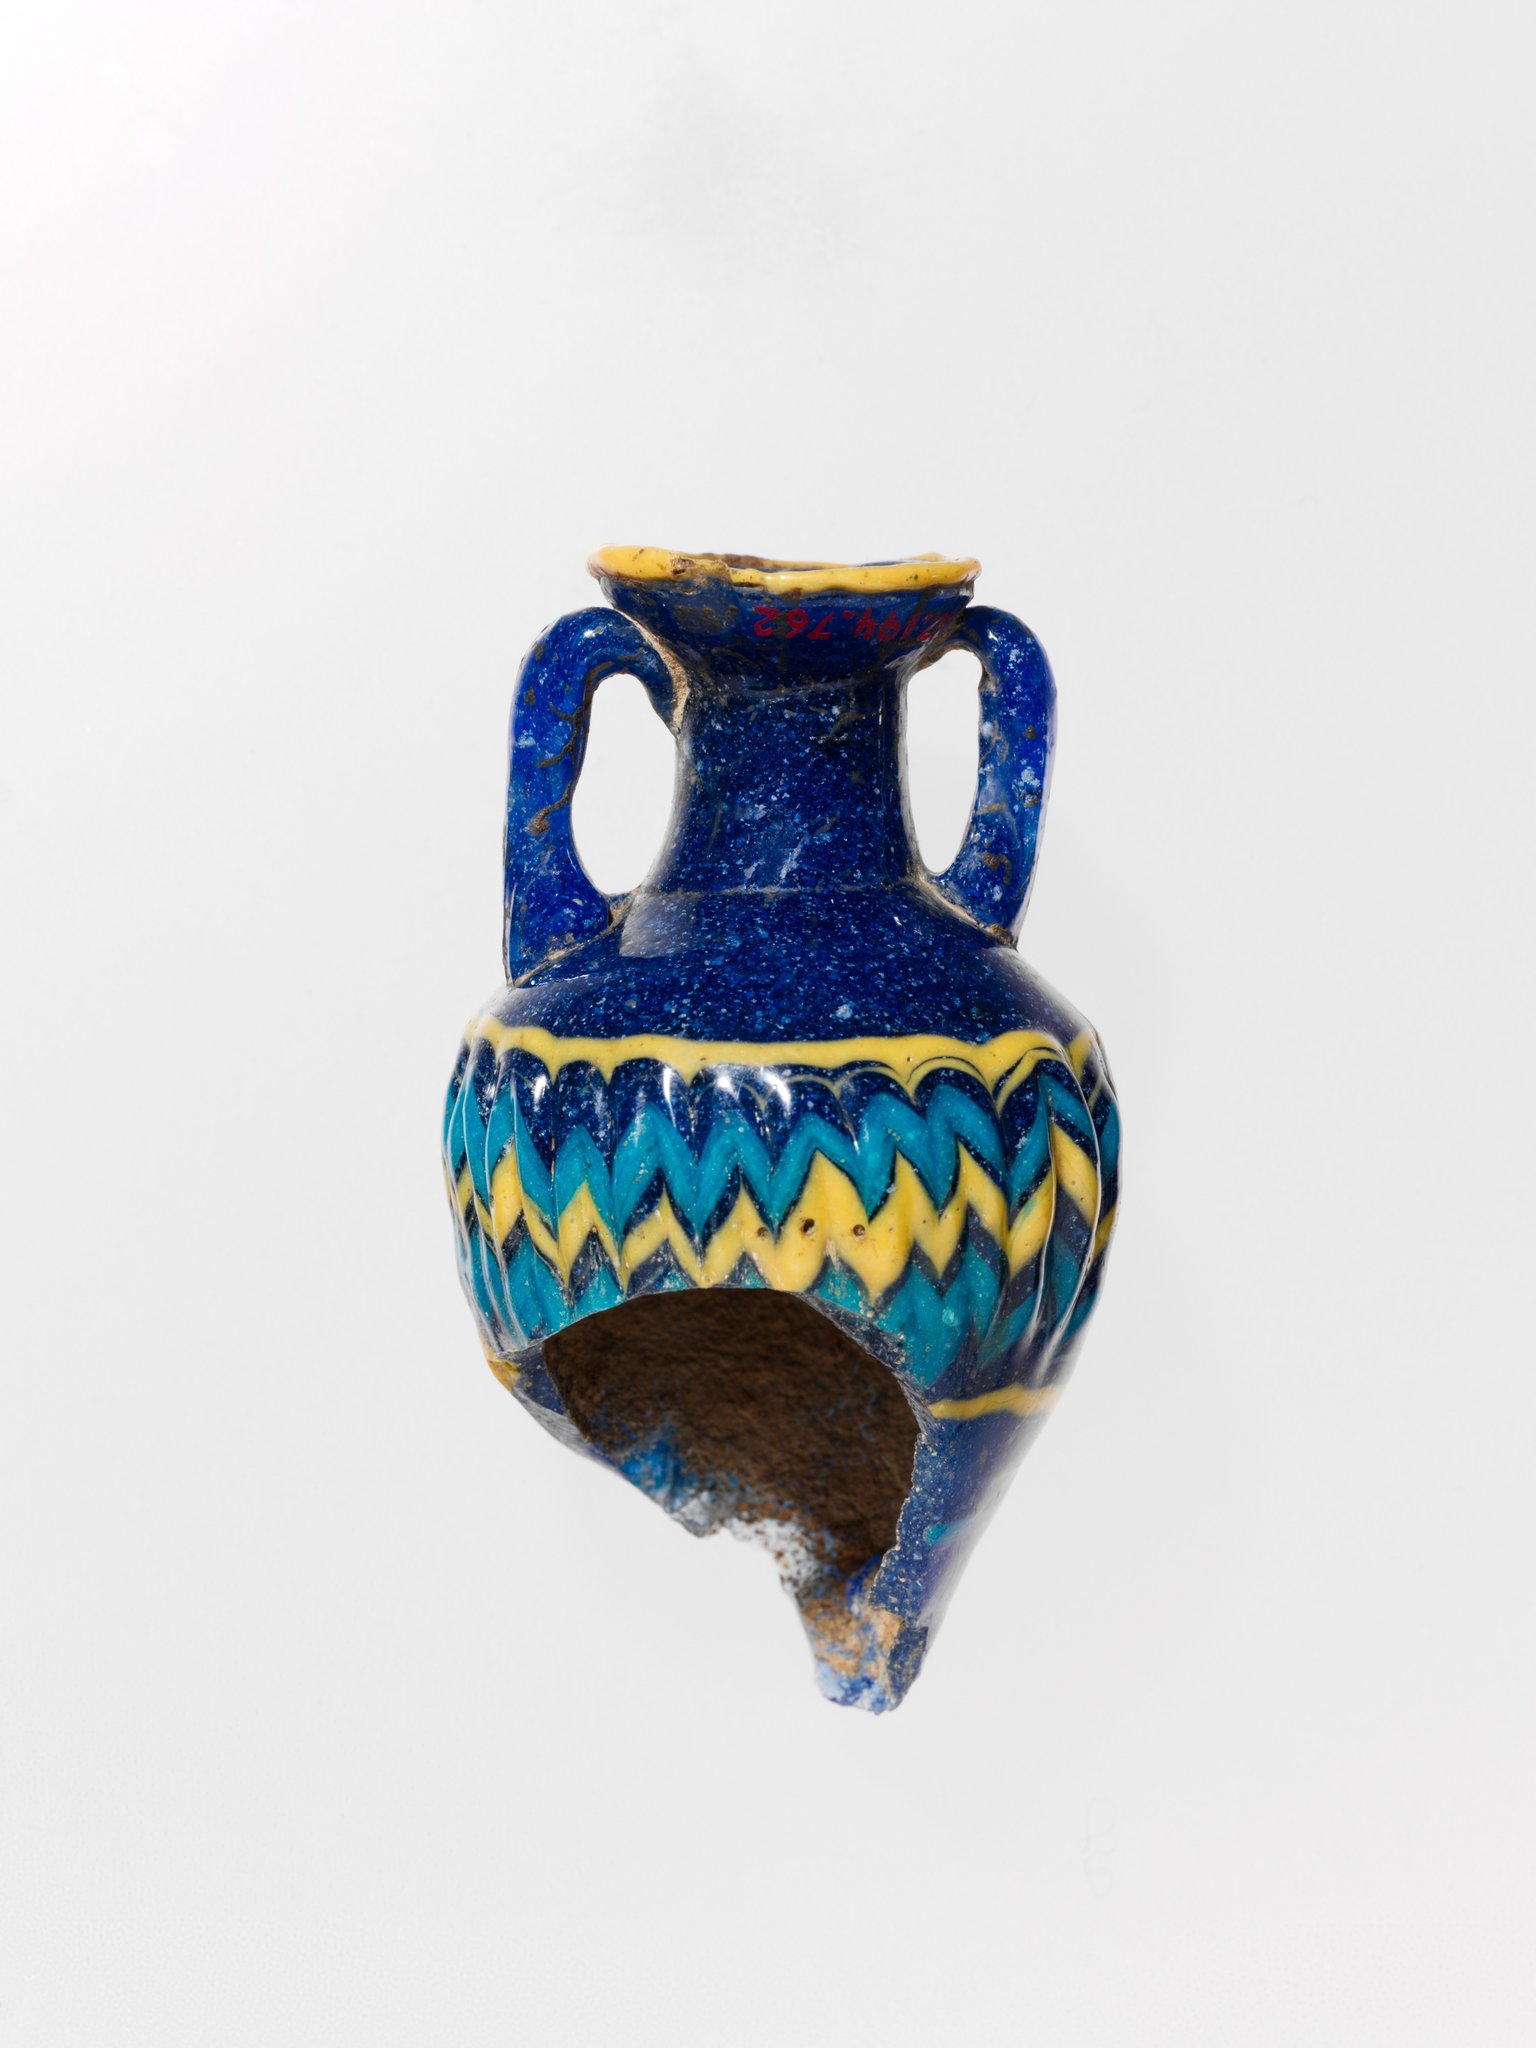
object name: amphoriskos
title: Glass amphoriskos (perfume bottle)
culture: greek, eastern mediterranean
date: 534-401 BCE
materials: glass